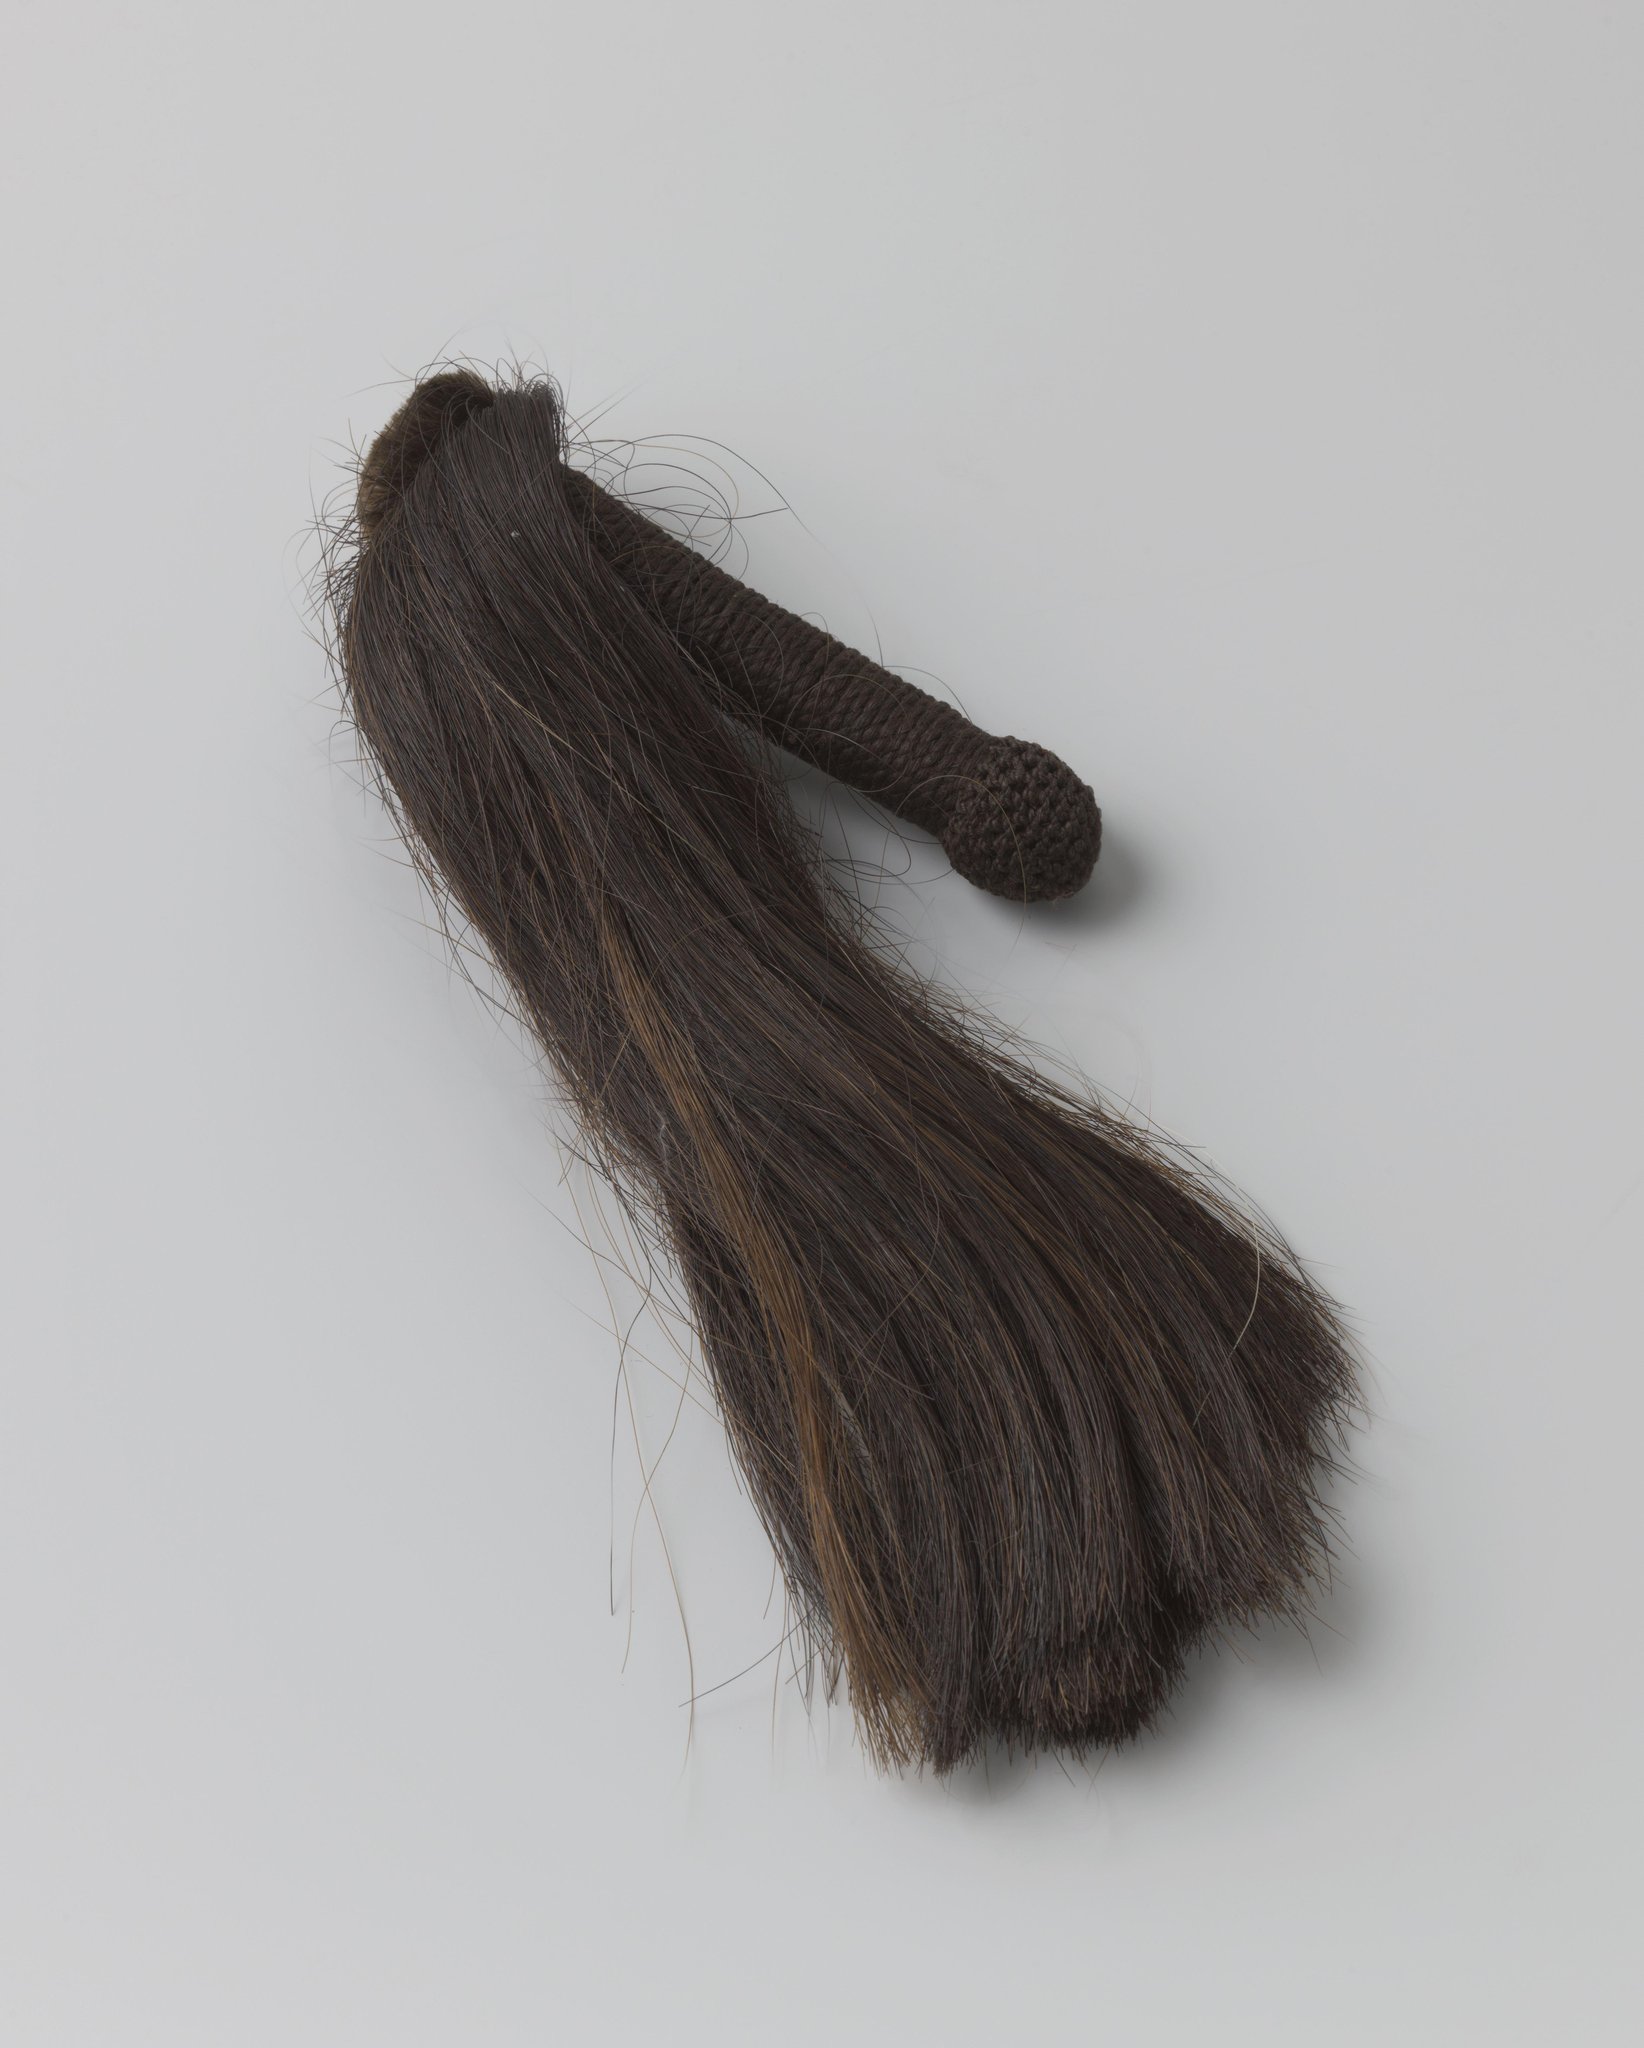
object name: plume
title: Pluim voor een sjako van een jager van Rookmakers, ca. 1831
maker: Anonymous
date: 1831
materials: hair, wool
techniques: stitching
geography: netherlands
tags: netherlands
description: Afhangende paardenharen pluim van een jager van "De jagers van rookmakers" ca. 1831. Vervaardigd van zwart paardenhaar, bekroond met pluim van, groene (?), wol. Gezet in houder omwikkeld met groen koord, onderzijde gevat in dito netwerk.